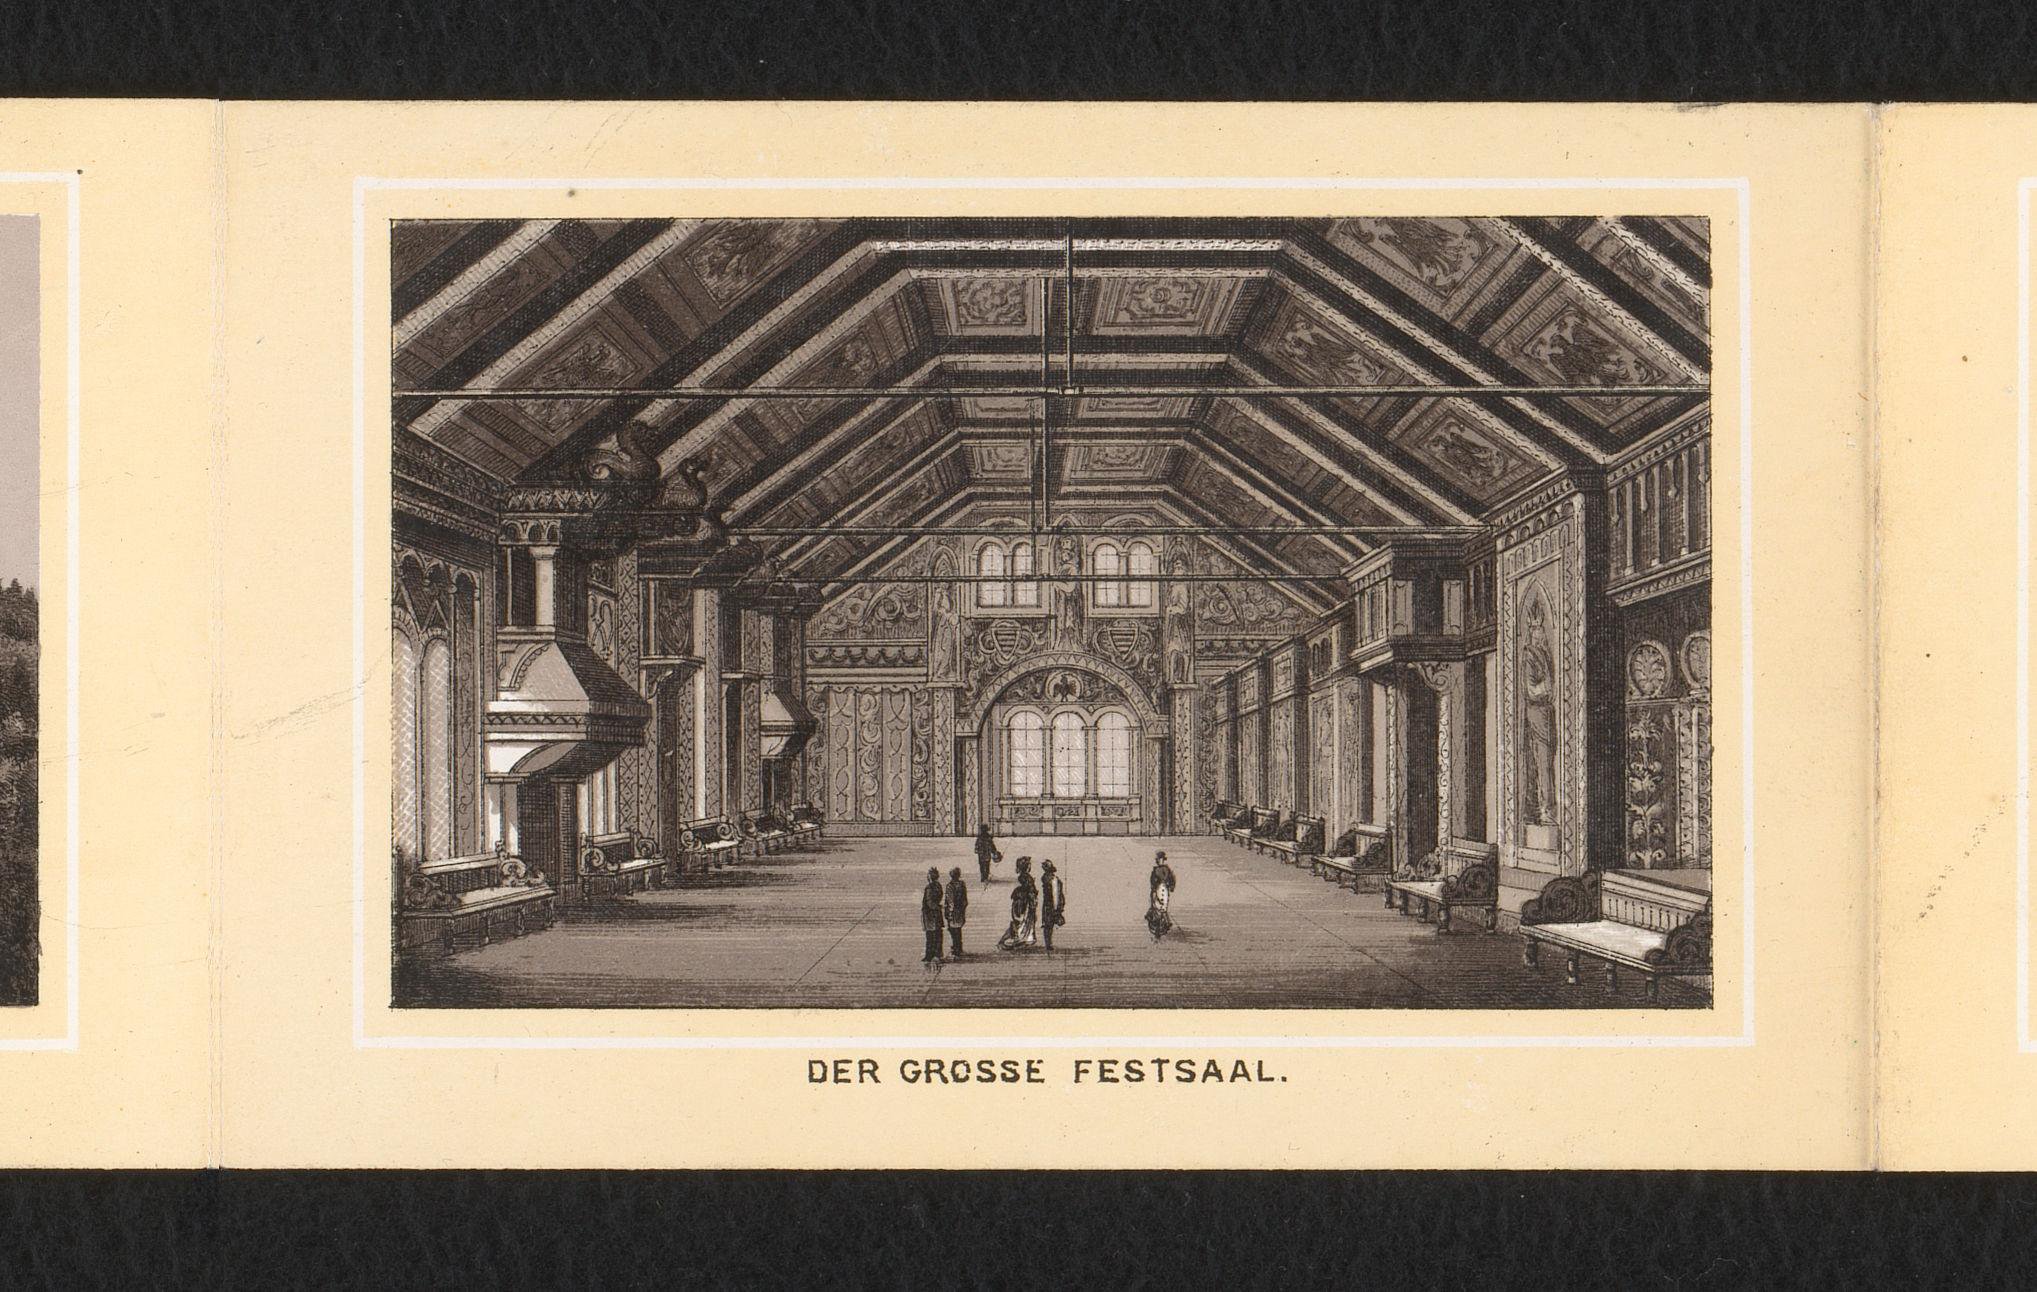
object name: photomechanical print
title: Der grosse Festsaal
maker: louis glaser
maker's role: printer, publisher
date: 1874-1900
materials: cardboard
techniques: photolithography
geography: leipzig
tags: castle, interior of the house